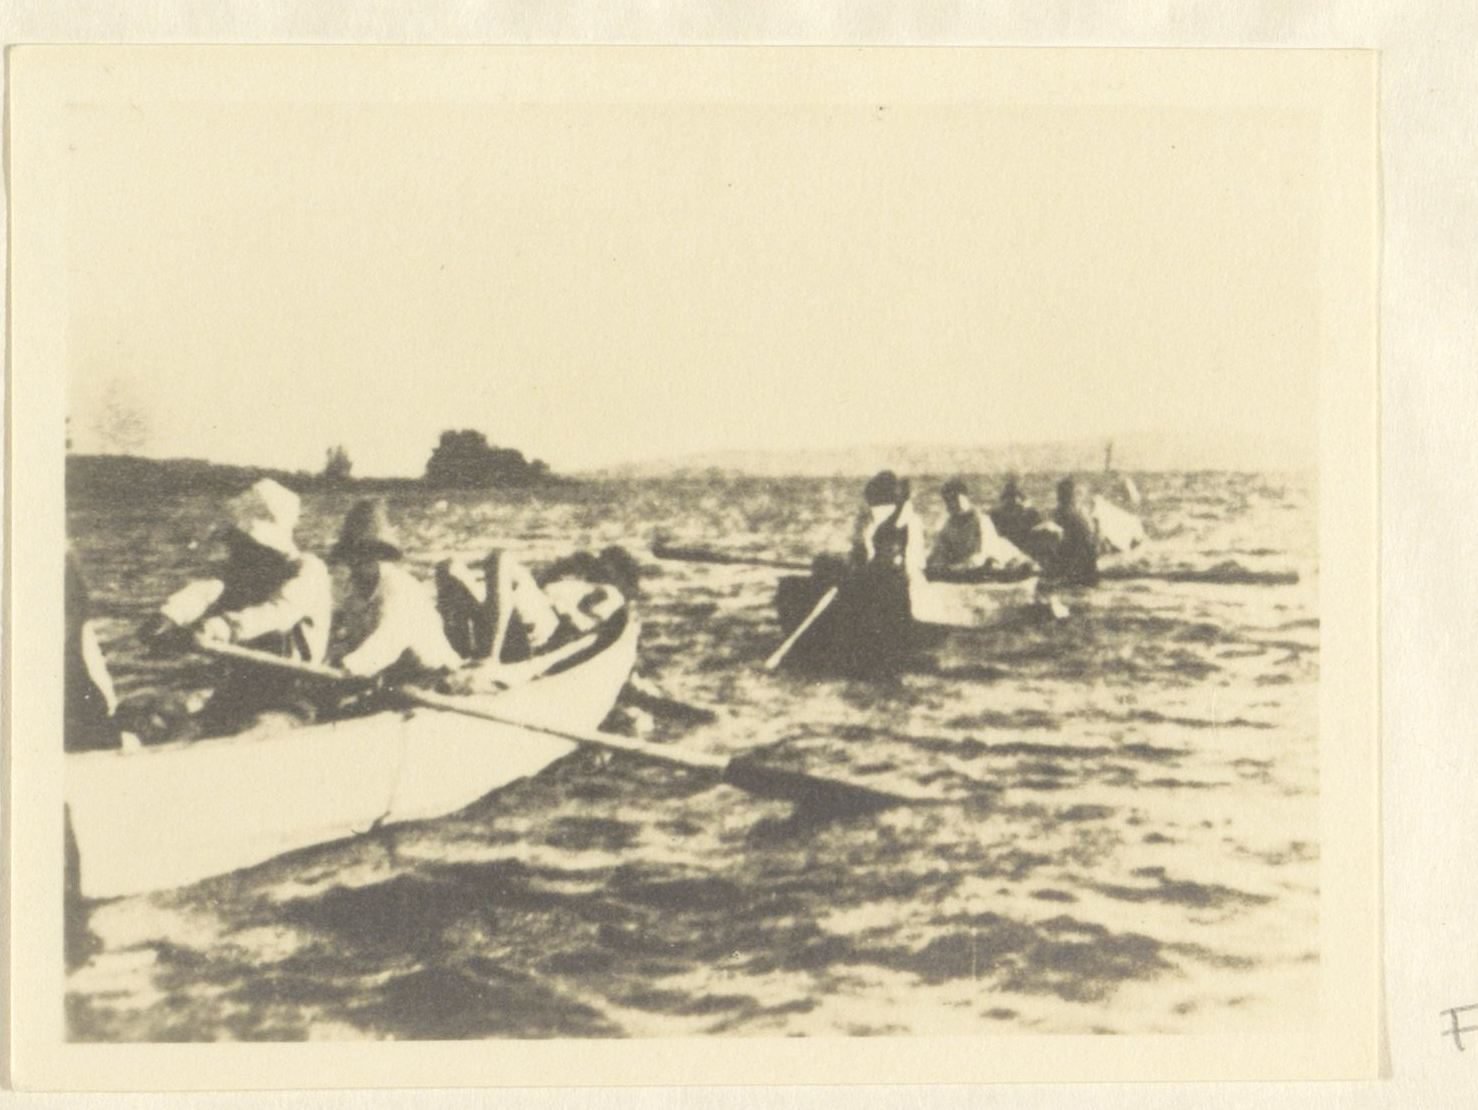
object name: photograph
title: Leerlingen van Schule Schloss Salem tijdens een boottocht op Finse meren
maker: Anonymous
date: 1925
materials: photographic support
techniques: gelatin silver print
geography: salem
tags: rowing-boat, canoe, etc., education, rowing, canoeing, etc. (sport)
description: Onderdeel van Fotoalbum van Schule Schloss Salem.